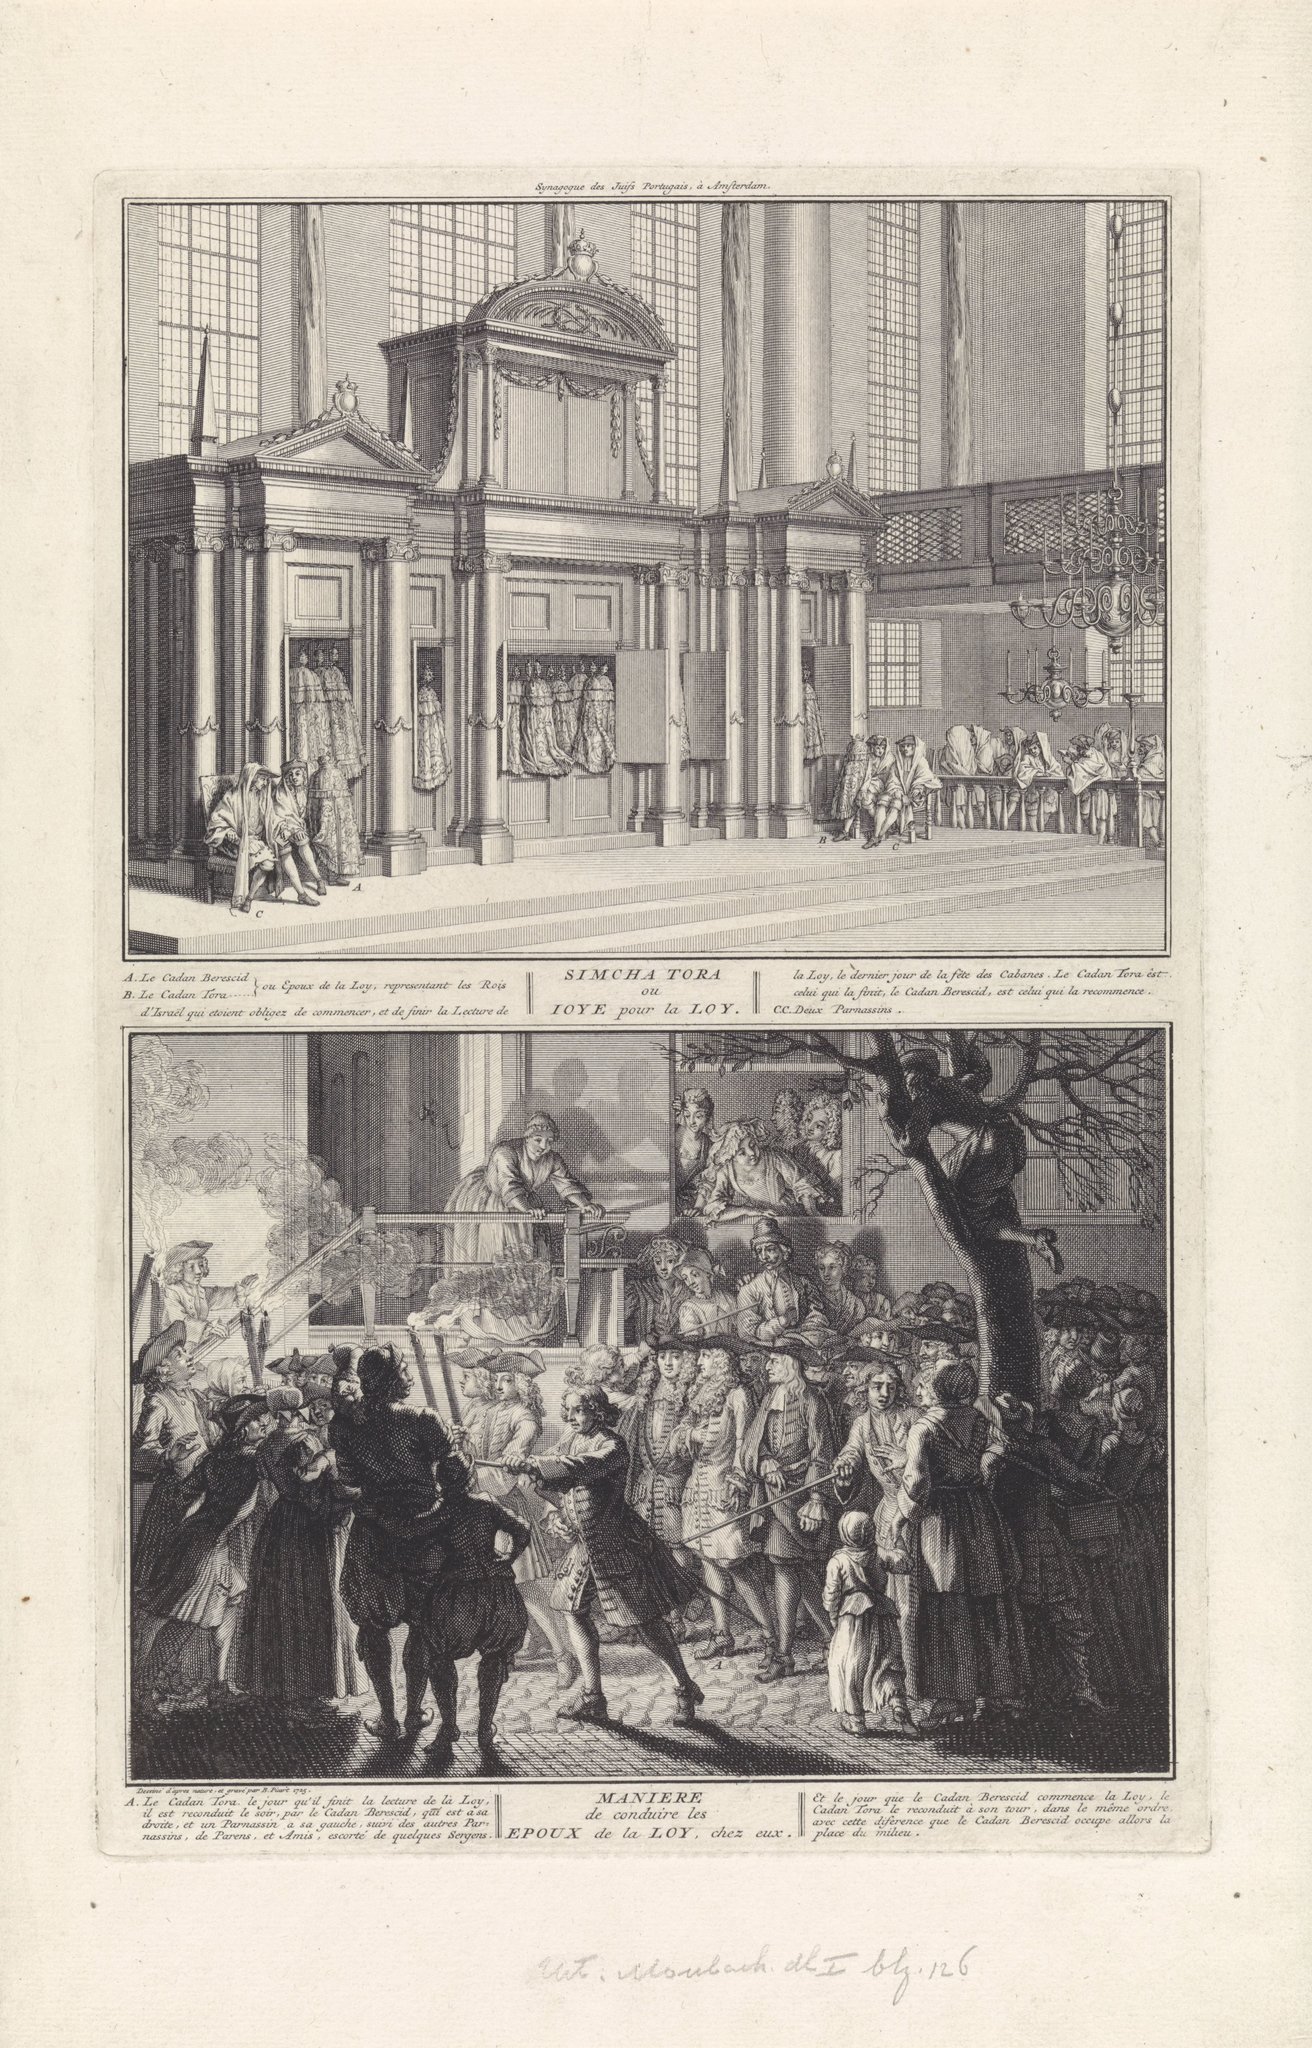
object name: print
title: Synagogue des Juifs Portugais, à Amsterdam / Simcha Tora ou Ioye pour la Loy / Maniere de conduire les epoux de la Loy, chez eux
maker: bernard picart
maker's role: draughtsman, print maker, publisher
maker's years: 1673-1733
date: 1725-1727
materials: paper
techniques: engraving, etching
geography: amsterdam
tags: 'simhat torah', rejoicing in the law ~ 'sukkot', 'simhat torah' procession: the 'hatan torah' and the 'hatan bereshit' are escorted in procession with torches and music from their homes to the synagogue and back, 'sephardim' ~ jewish communities, the synagogue (as building and place of worship ~ jewish religion), amsterdam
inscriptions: collector's mark: Lugt 240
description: Blad met twee voorstellingen van joodse gebruiken rond de viering van Simchat Thora of Vreugde der Wet. Boven: in de Portugese Synagoge te Amsterdam is de kast waarin de boekrollen worden bewaard geopend. Aan de linker zijde van de kast zit een zogeheten bruidegom van de wet met de boekrol Beresjiet (Genesis) en aan de rechter zijde een bruidegom van de wet met de laatste boekrol van de Thora: Dewariem (Deuteronomium). Onder: de bruidegoms van de wet, de lezers van de Thora, worden in een processie met fakkels begeleid op het feest van Simchat Thora of Vreugde der Wet. Onder de afbeeldingen een toelichting in het Frans.